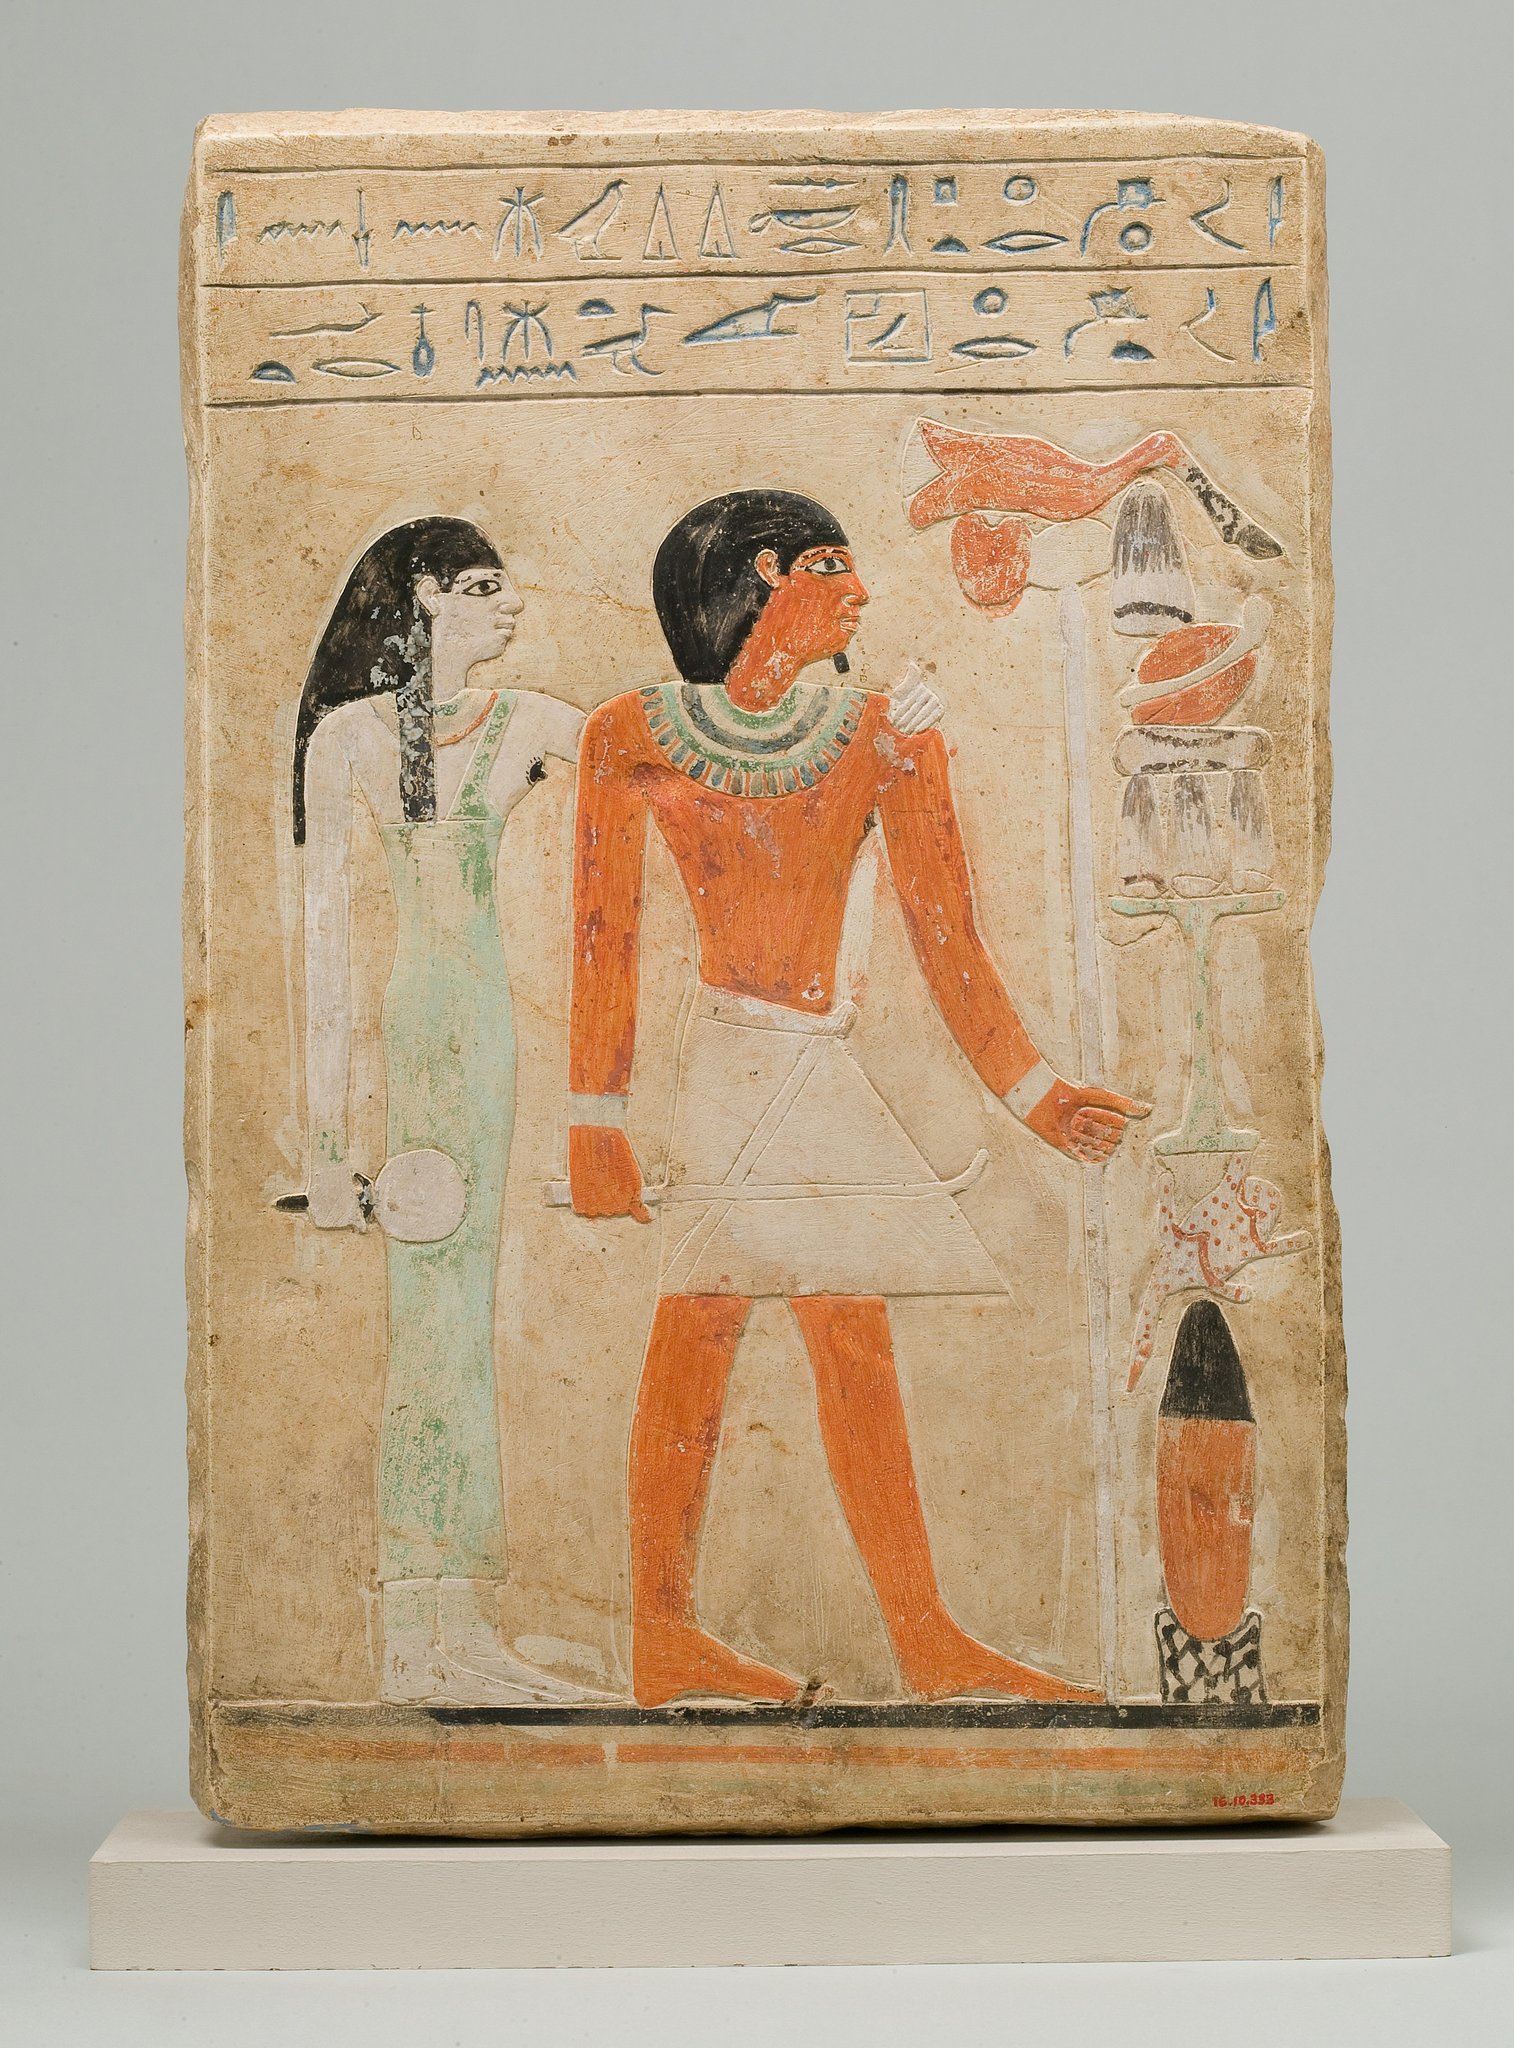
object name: stela, dedu, sitsobek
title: Stela of Dedu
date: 2000-1952 BCE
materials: limestone, paint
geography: egypt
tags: men,women,hieroglyphs